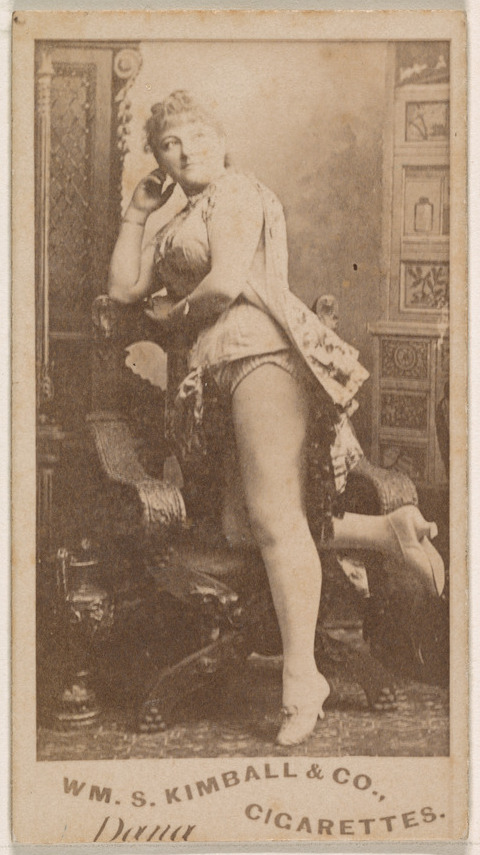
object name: photograph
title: Miss Dana, from the Actresses series (N203) issued by Wm. S. Kimball & Co.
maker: william s. kimball & company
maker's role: publisher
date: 1889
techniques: color lithograph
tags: portraits,women,actresses